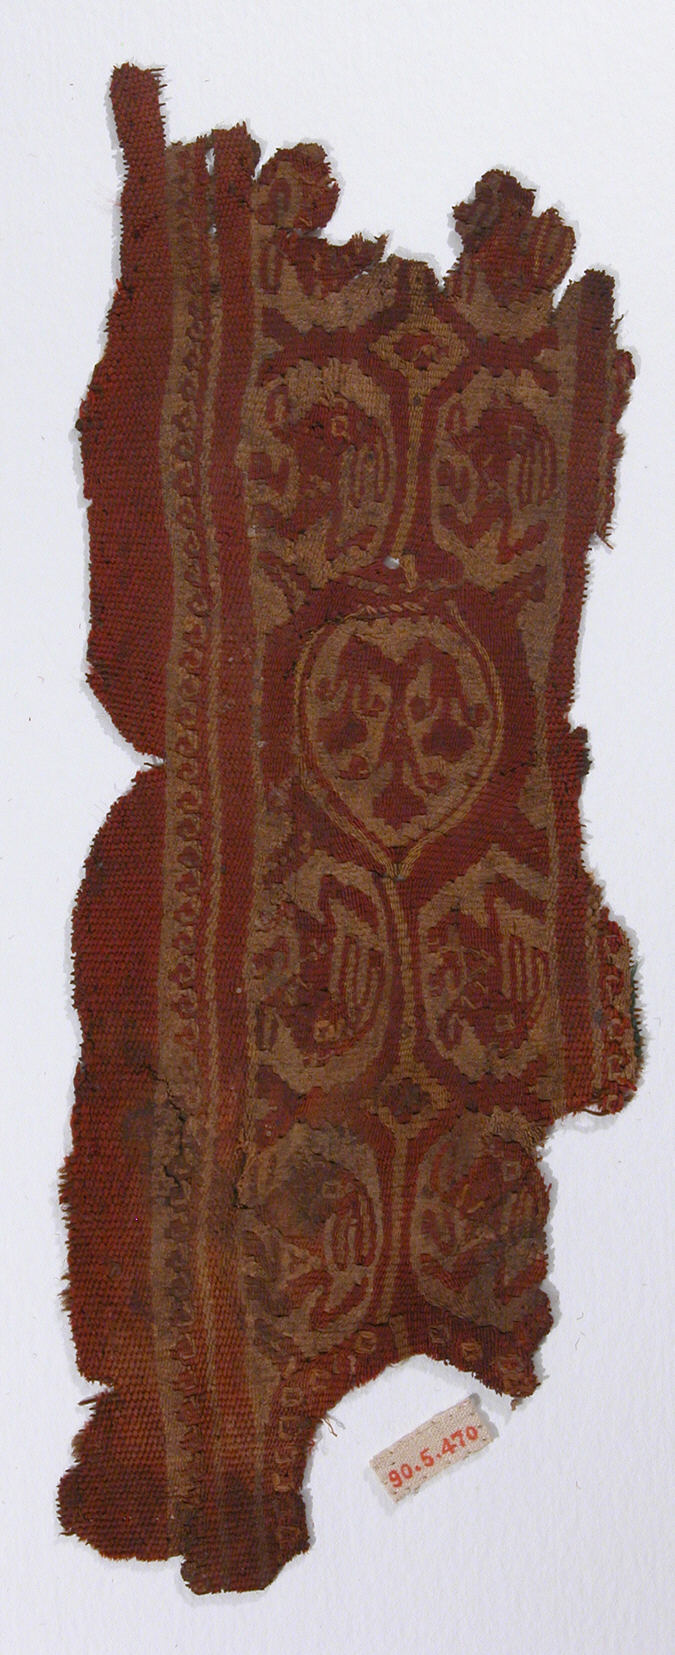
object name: textile fragment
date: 201-400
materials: linen, wool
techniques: weave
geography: egypt